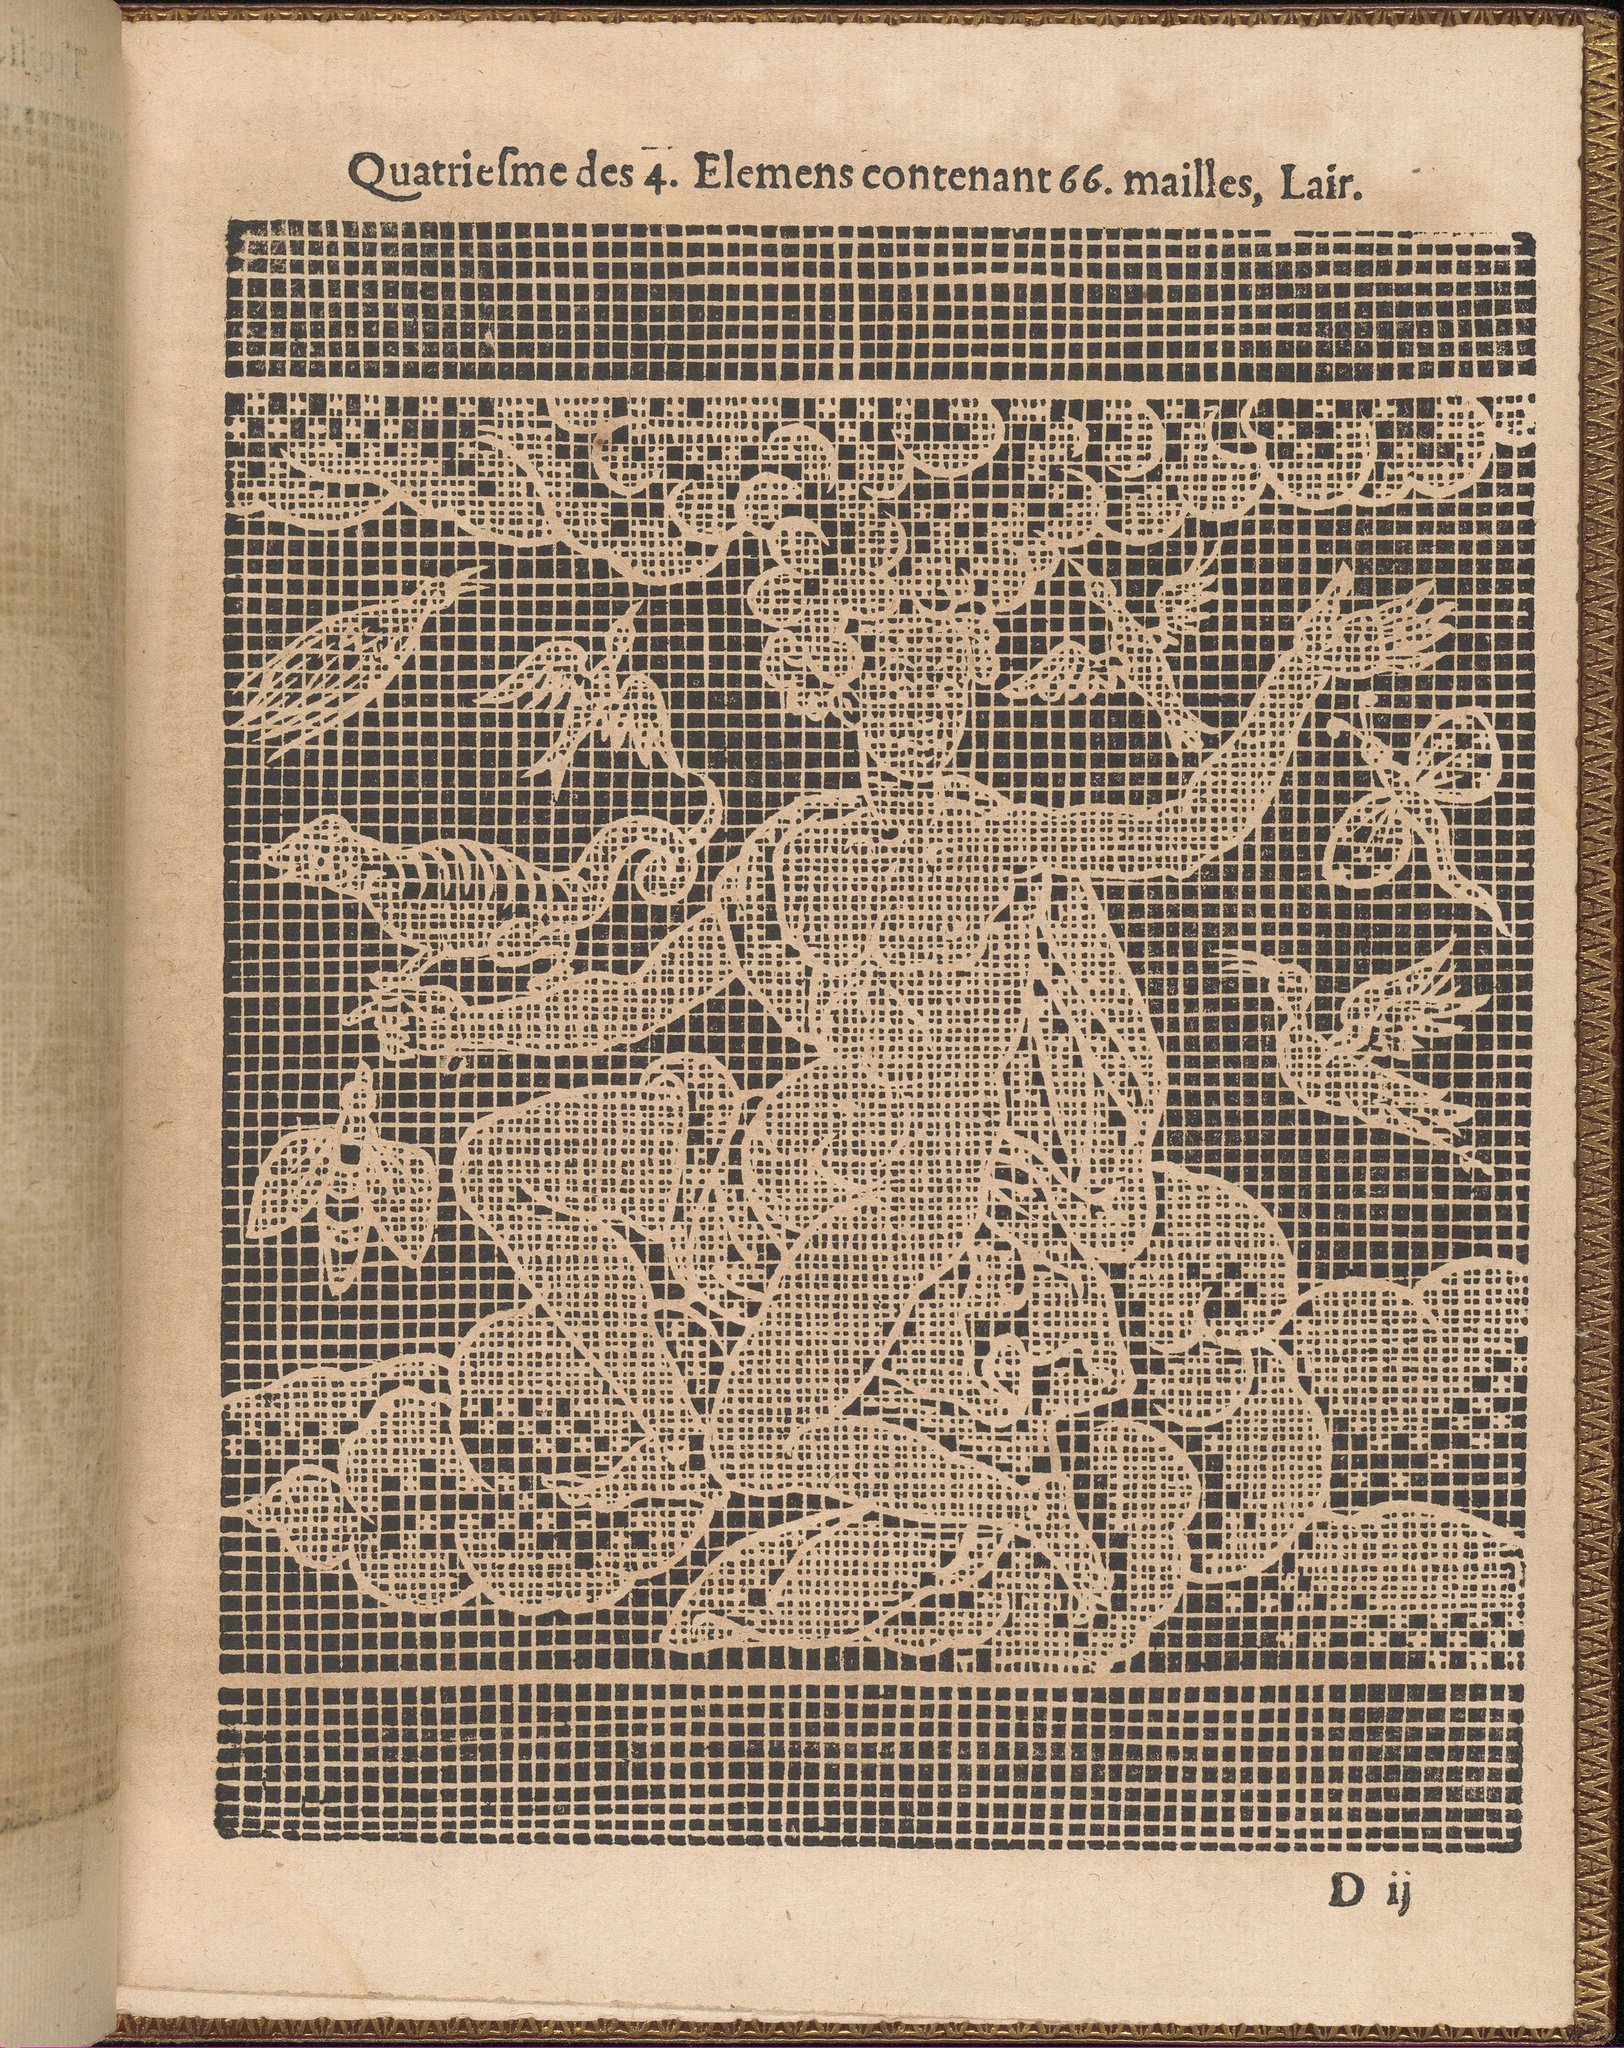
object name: book print ornament architecture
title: La Pratique de l'Aiguille, page 13 (recto)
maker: matthias mignerak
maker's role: author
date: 1605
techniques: woodcut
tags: birds,women,insects,lizards